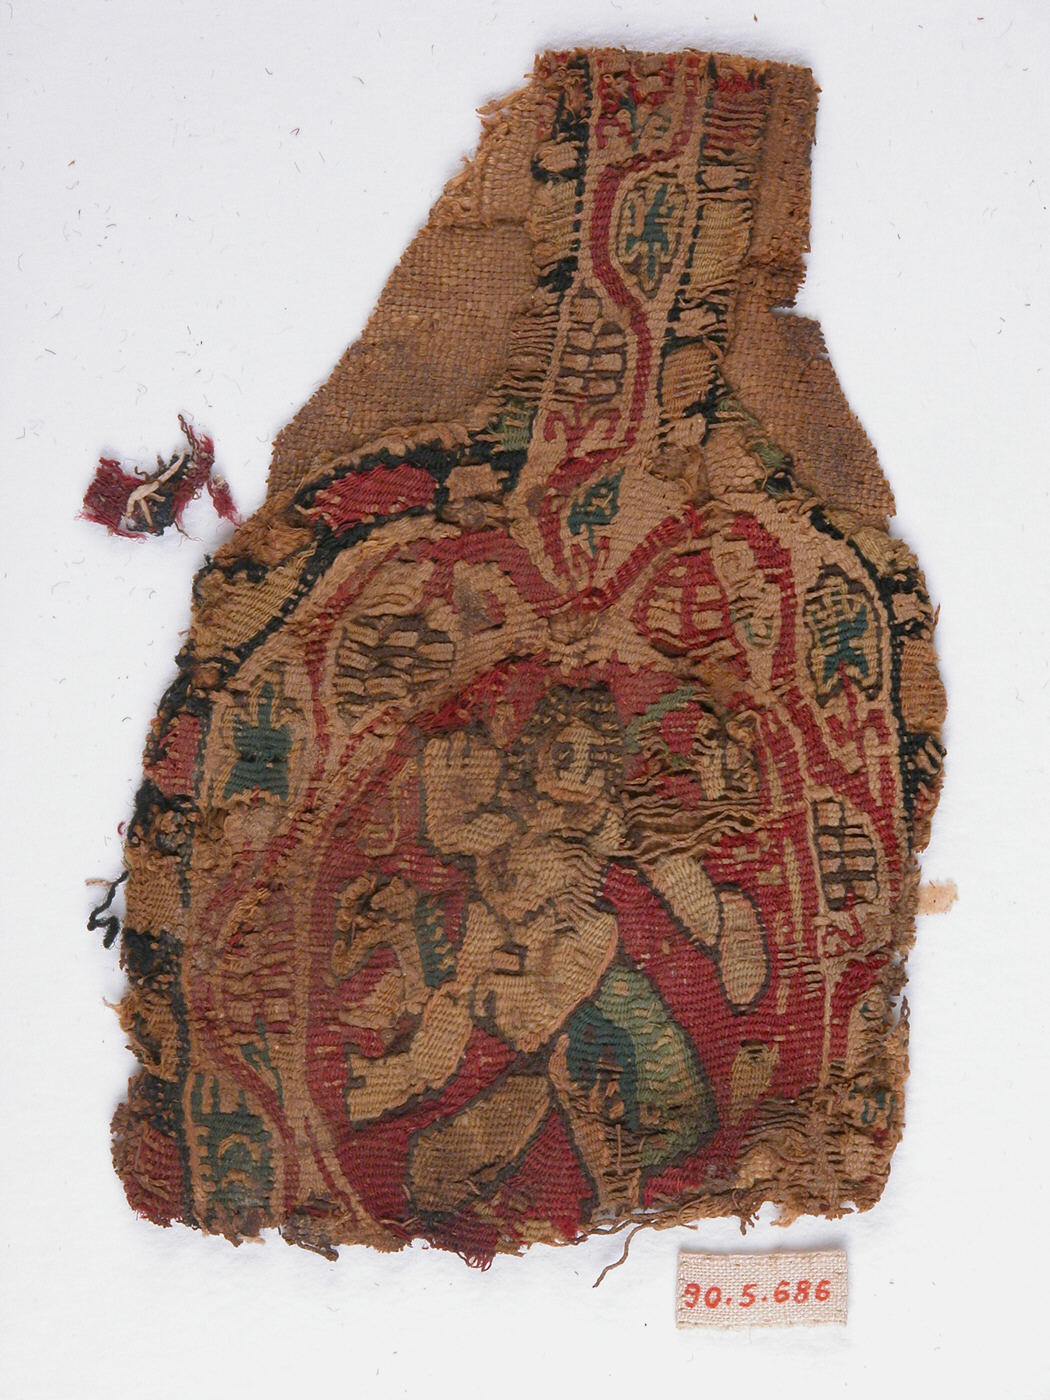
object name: textile fragment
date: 501-600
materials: linen, wool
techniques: weave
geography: egypt